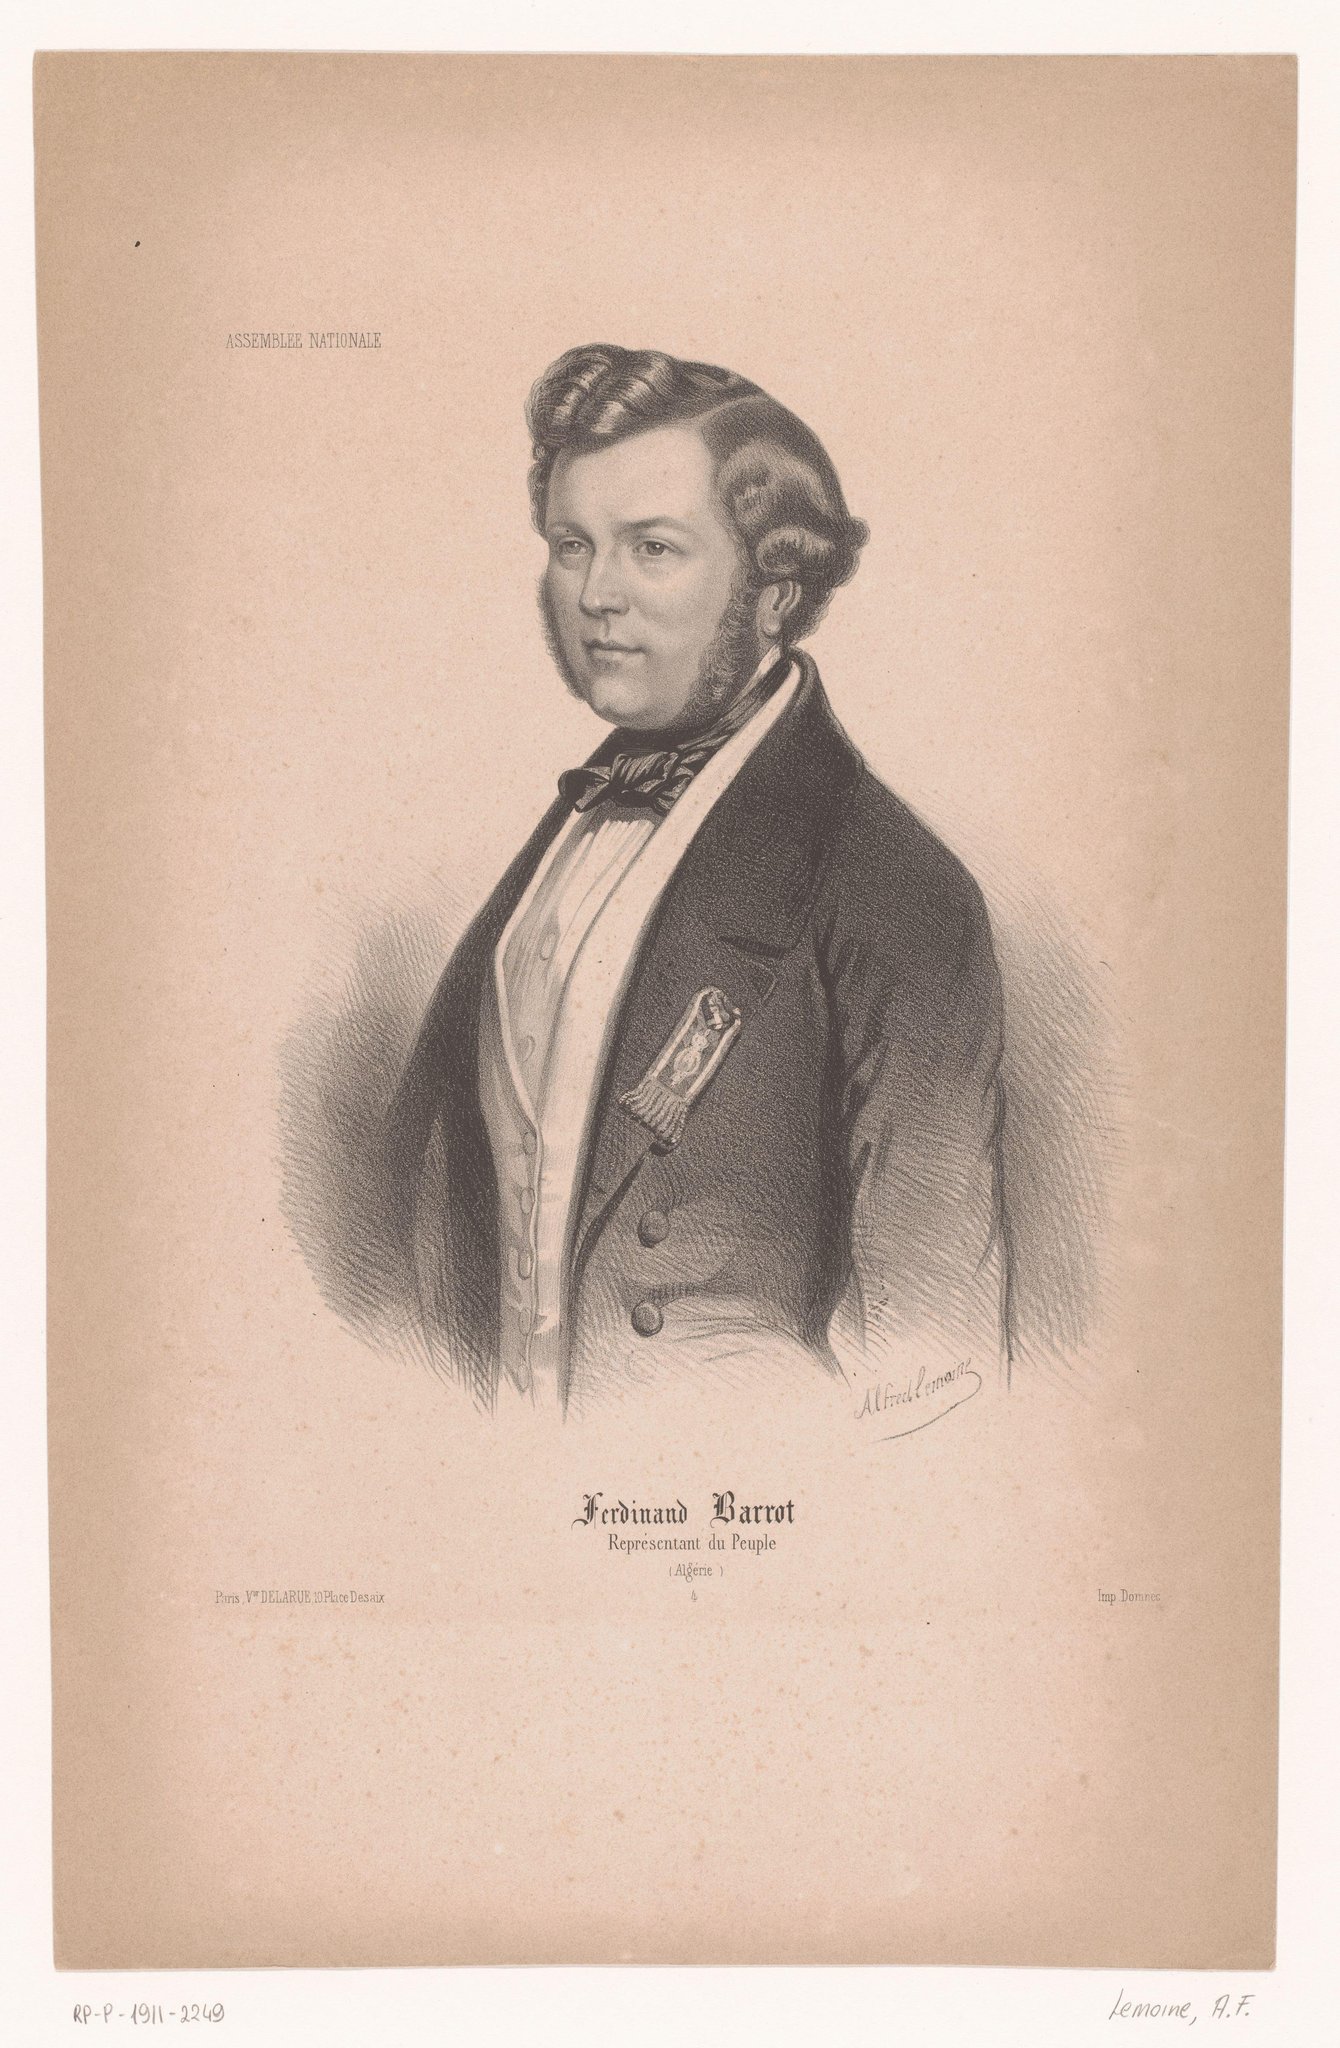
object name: print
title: Assemblée Nationale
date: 1848-1849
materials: paper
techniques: lithograph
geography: paris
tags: paris, politician, historical persons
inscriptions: collector's mark: Lugt 2228a